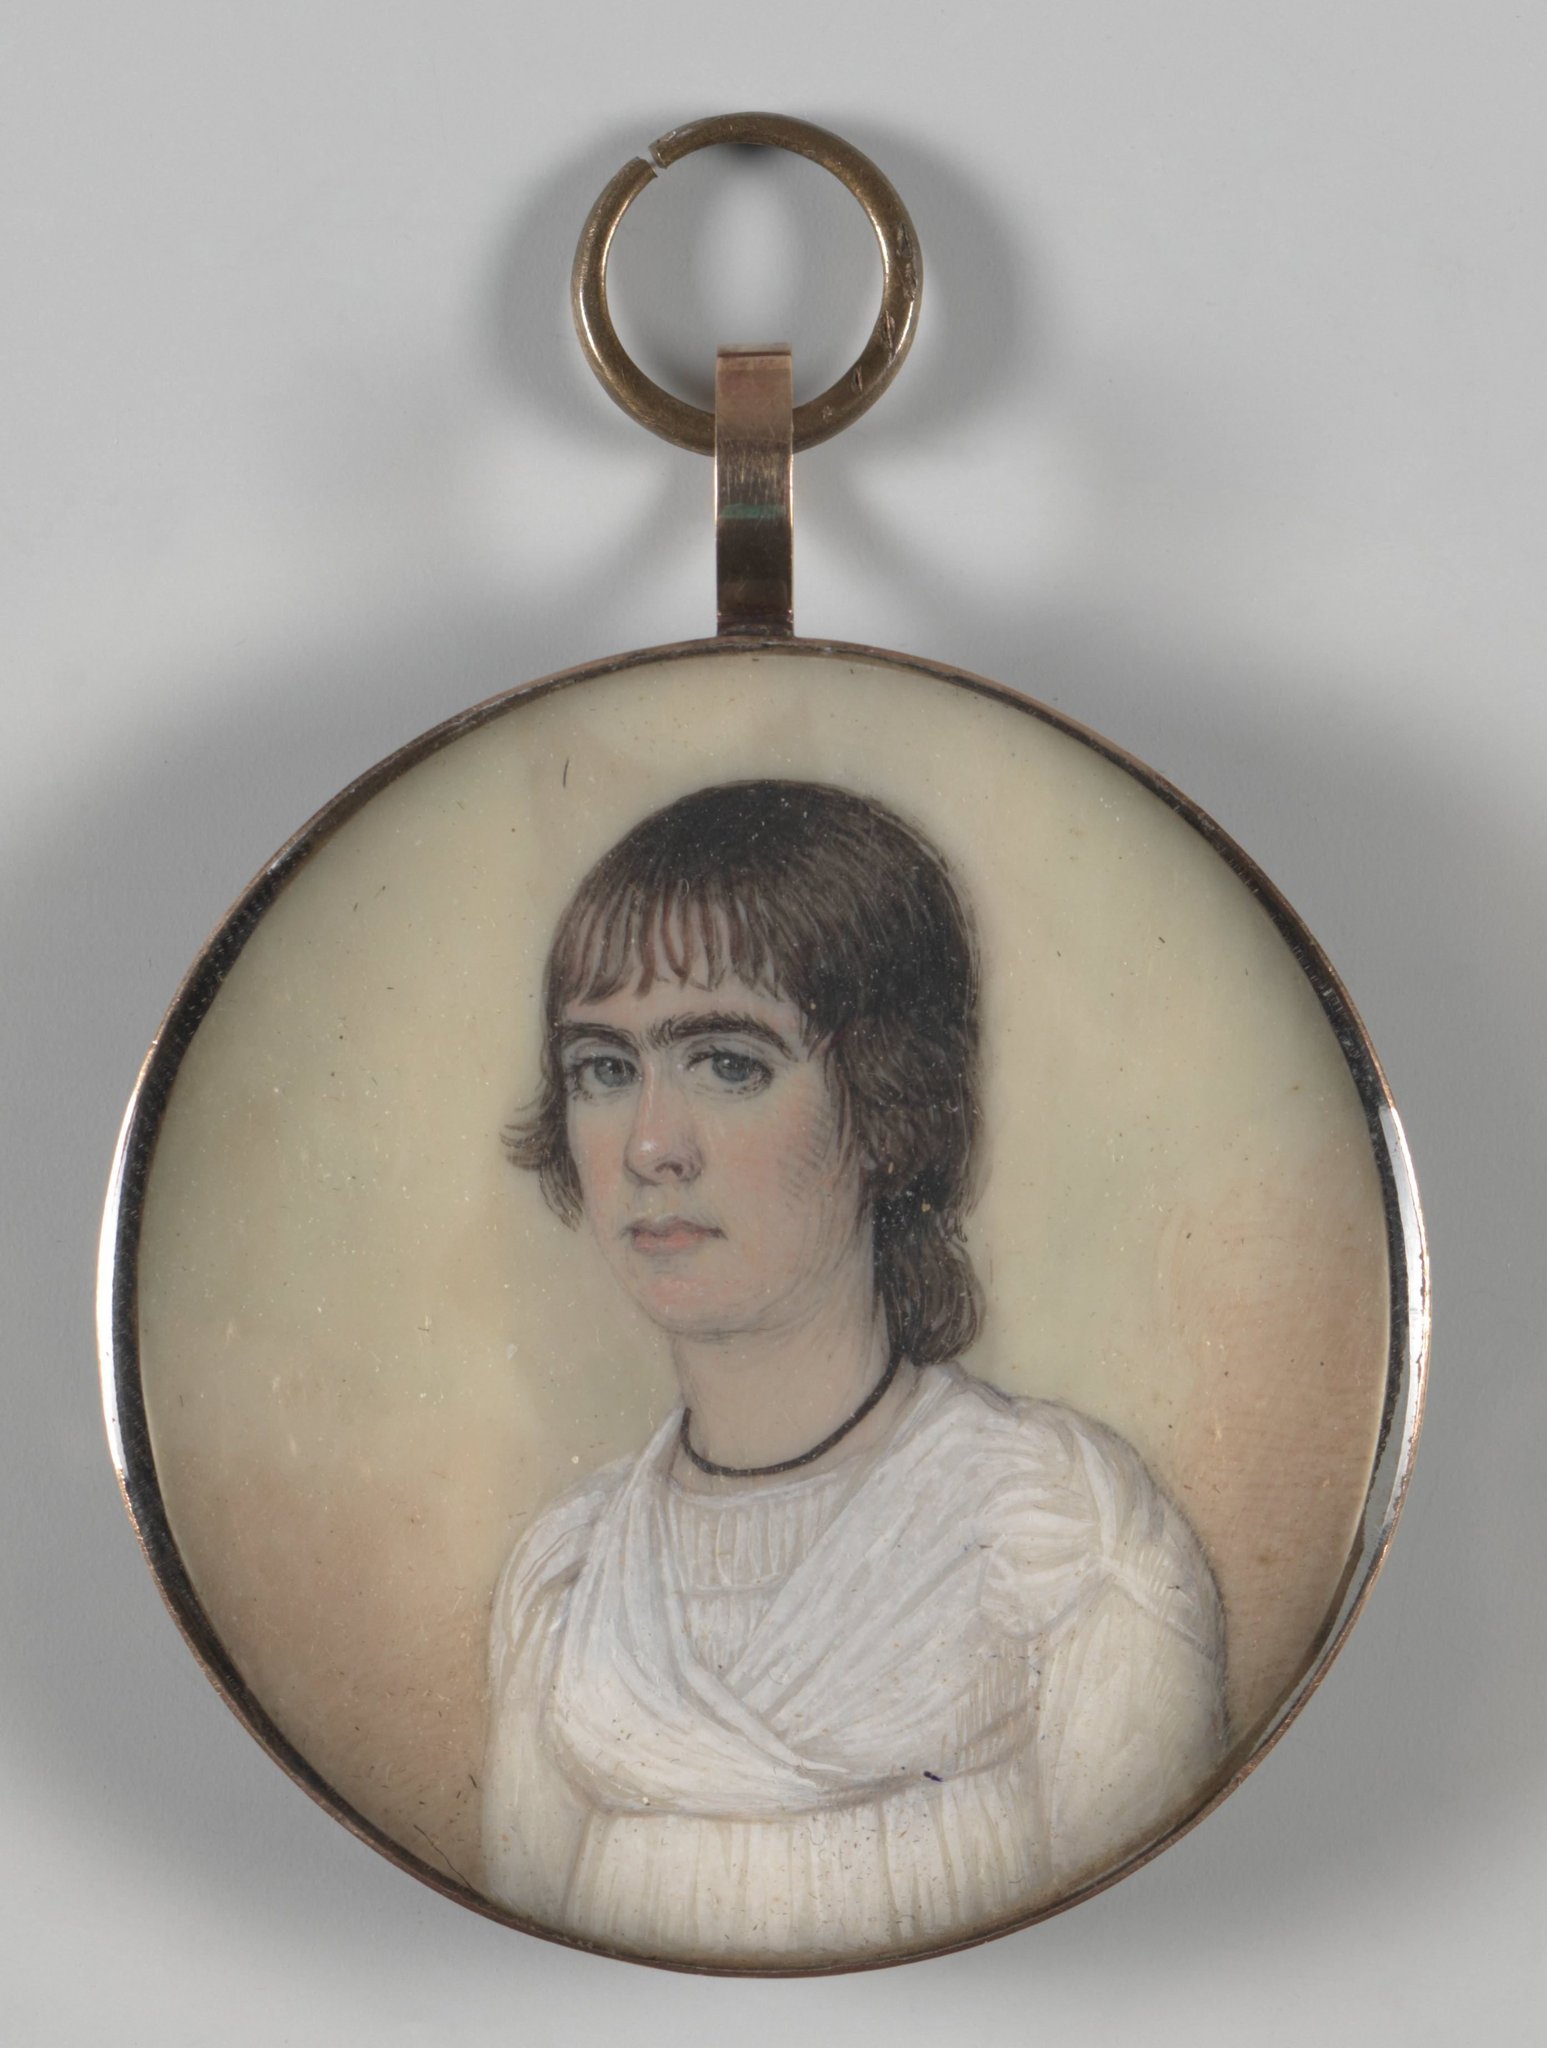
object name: painting, miniature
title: Portraits of Surinamese Girls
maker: Anonymous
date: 1805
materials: ivory, metal, paint, wood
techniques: gilding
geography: suriname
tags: historical persons - bb - woman, suriname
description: We may not know the identities of these women, but their status is apparent from their clothing, jewellery, and the existence of portraits depicting them. They must have been free women who held positions in Surinamese society. One of them wears a white-cotton angisa, a headscarf folded in a special way. It was worn by enslaved women as well as free women of colour.